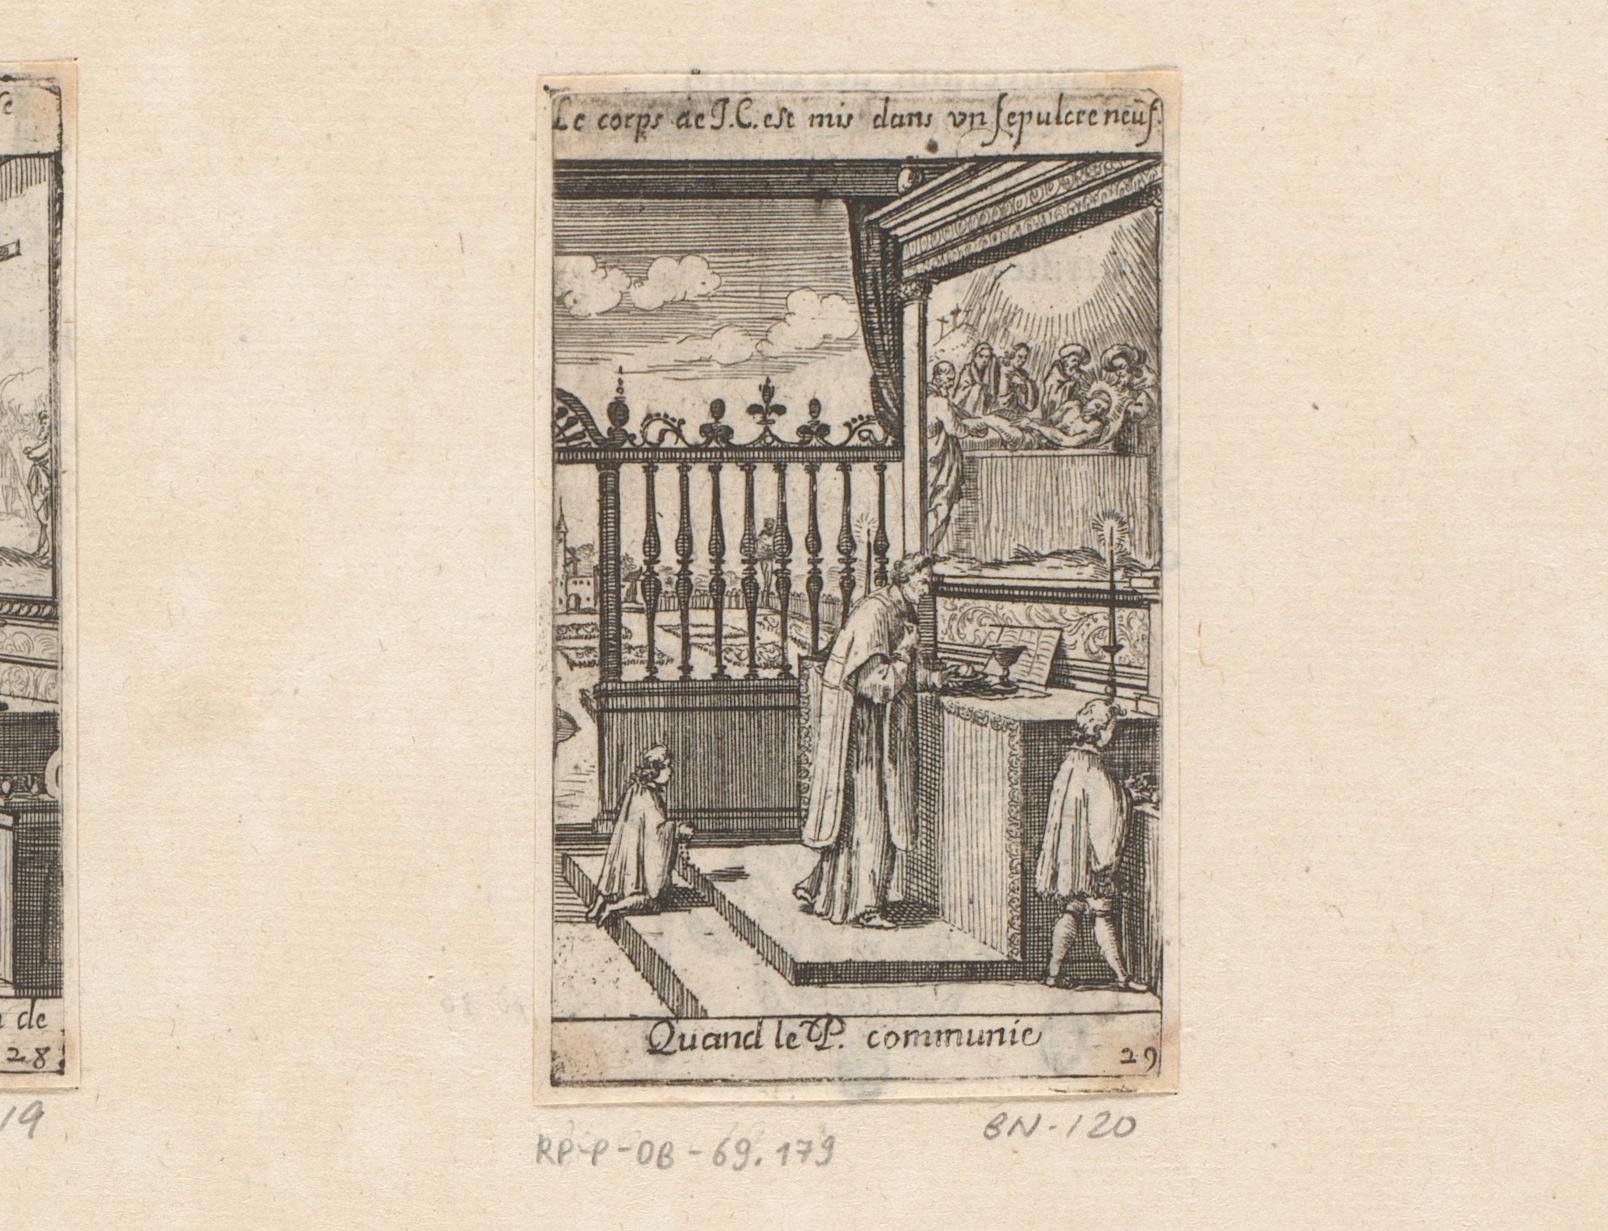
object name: book illustration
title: Priester met twee misdienaars voor een altaar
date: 1661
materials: paper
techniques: etching, letterpress printing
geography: france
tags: priest (roman catholic), altar with altar-piece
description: Prent uit: Mengin, L. Tableaux ou sont representees la passion de N.S. Christ et les actions du prestre a la S. Messe (...). Metz: Claude Bouchard, 1661.